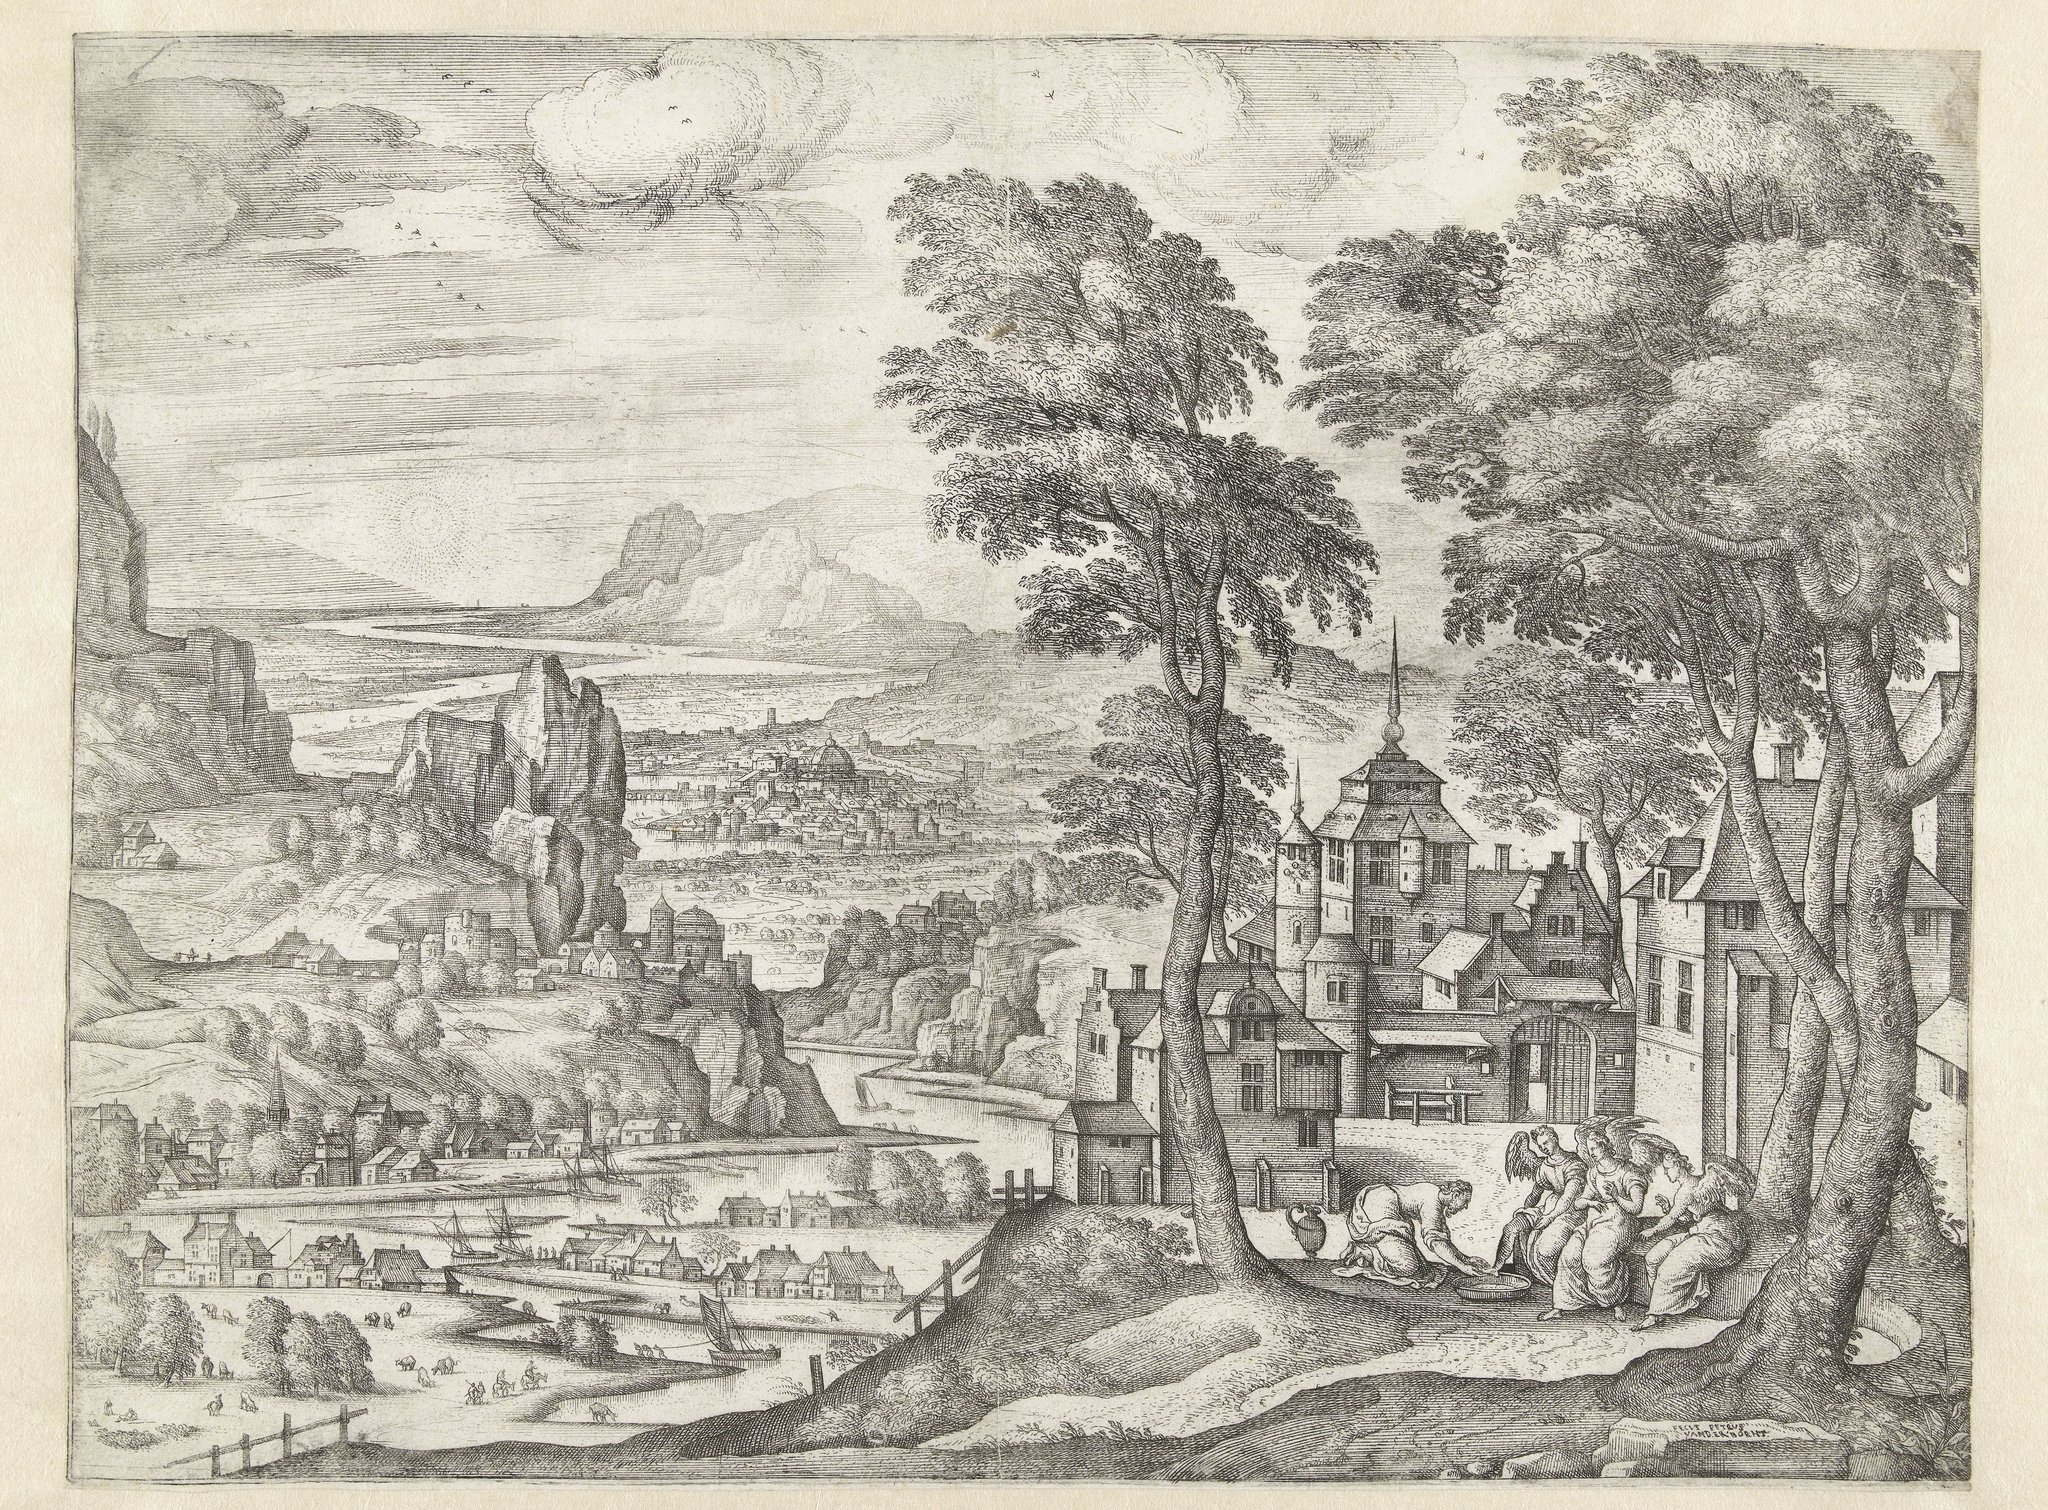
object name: print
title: Landschappen met het verhaal van Abraham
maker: pieter van der borcht (i)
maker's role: print maker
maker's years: 1545-1608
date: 1586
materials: paper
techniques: etching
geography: antwerp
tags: dale, valley, abraham fetches water and washes the angels' feet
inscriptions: collector's mark: Lugt 2228, collector's mark: Lugt 796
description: Landschap met rechts Abraham die de voeten van de drie engelen wast (Gen. 18:4).